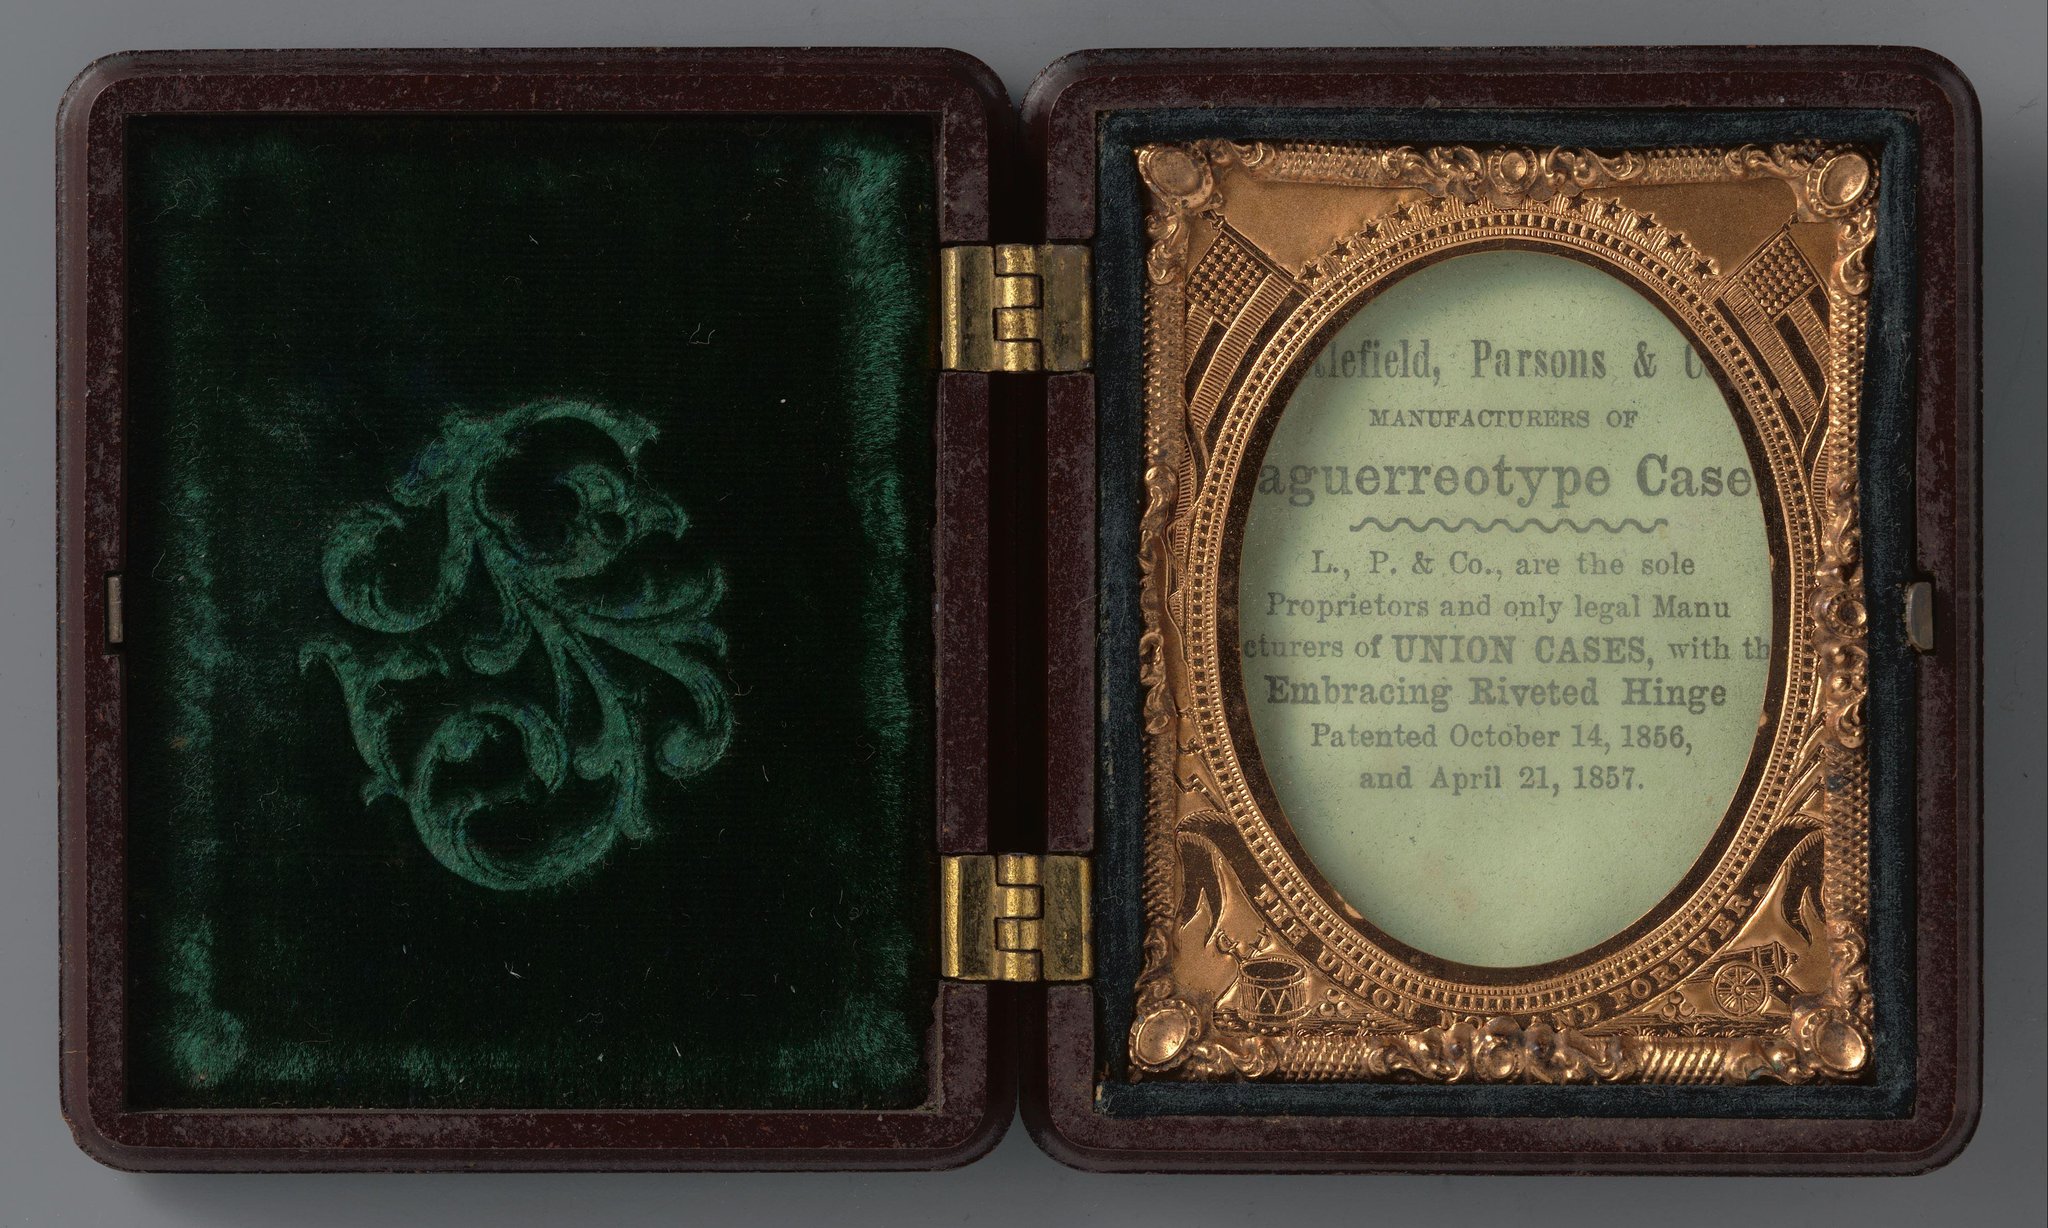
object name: union case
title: Lege union case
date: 1858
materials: glass, metal, paper, plastic, velvet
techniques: letterpress printing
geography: united states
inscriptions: inscription: ‘The Union Now and Forever’, inscription: ‘Littlefield, Parsons & Co./ Manufacturers of/ Daguerreotype Cases/ L., P. & Co., are the sole/ Proprietors and only legal Manu/ facturers of UNION CASES, with the/ Embracing Riveted Hinge/ Patented October 14, 1856,/ and April 21, 1857.’, inscription: ‘Rinhart American Miniature Case Art (...) 11/4 76 f50. (zonder foto)’